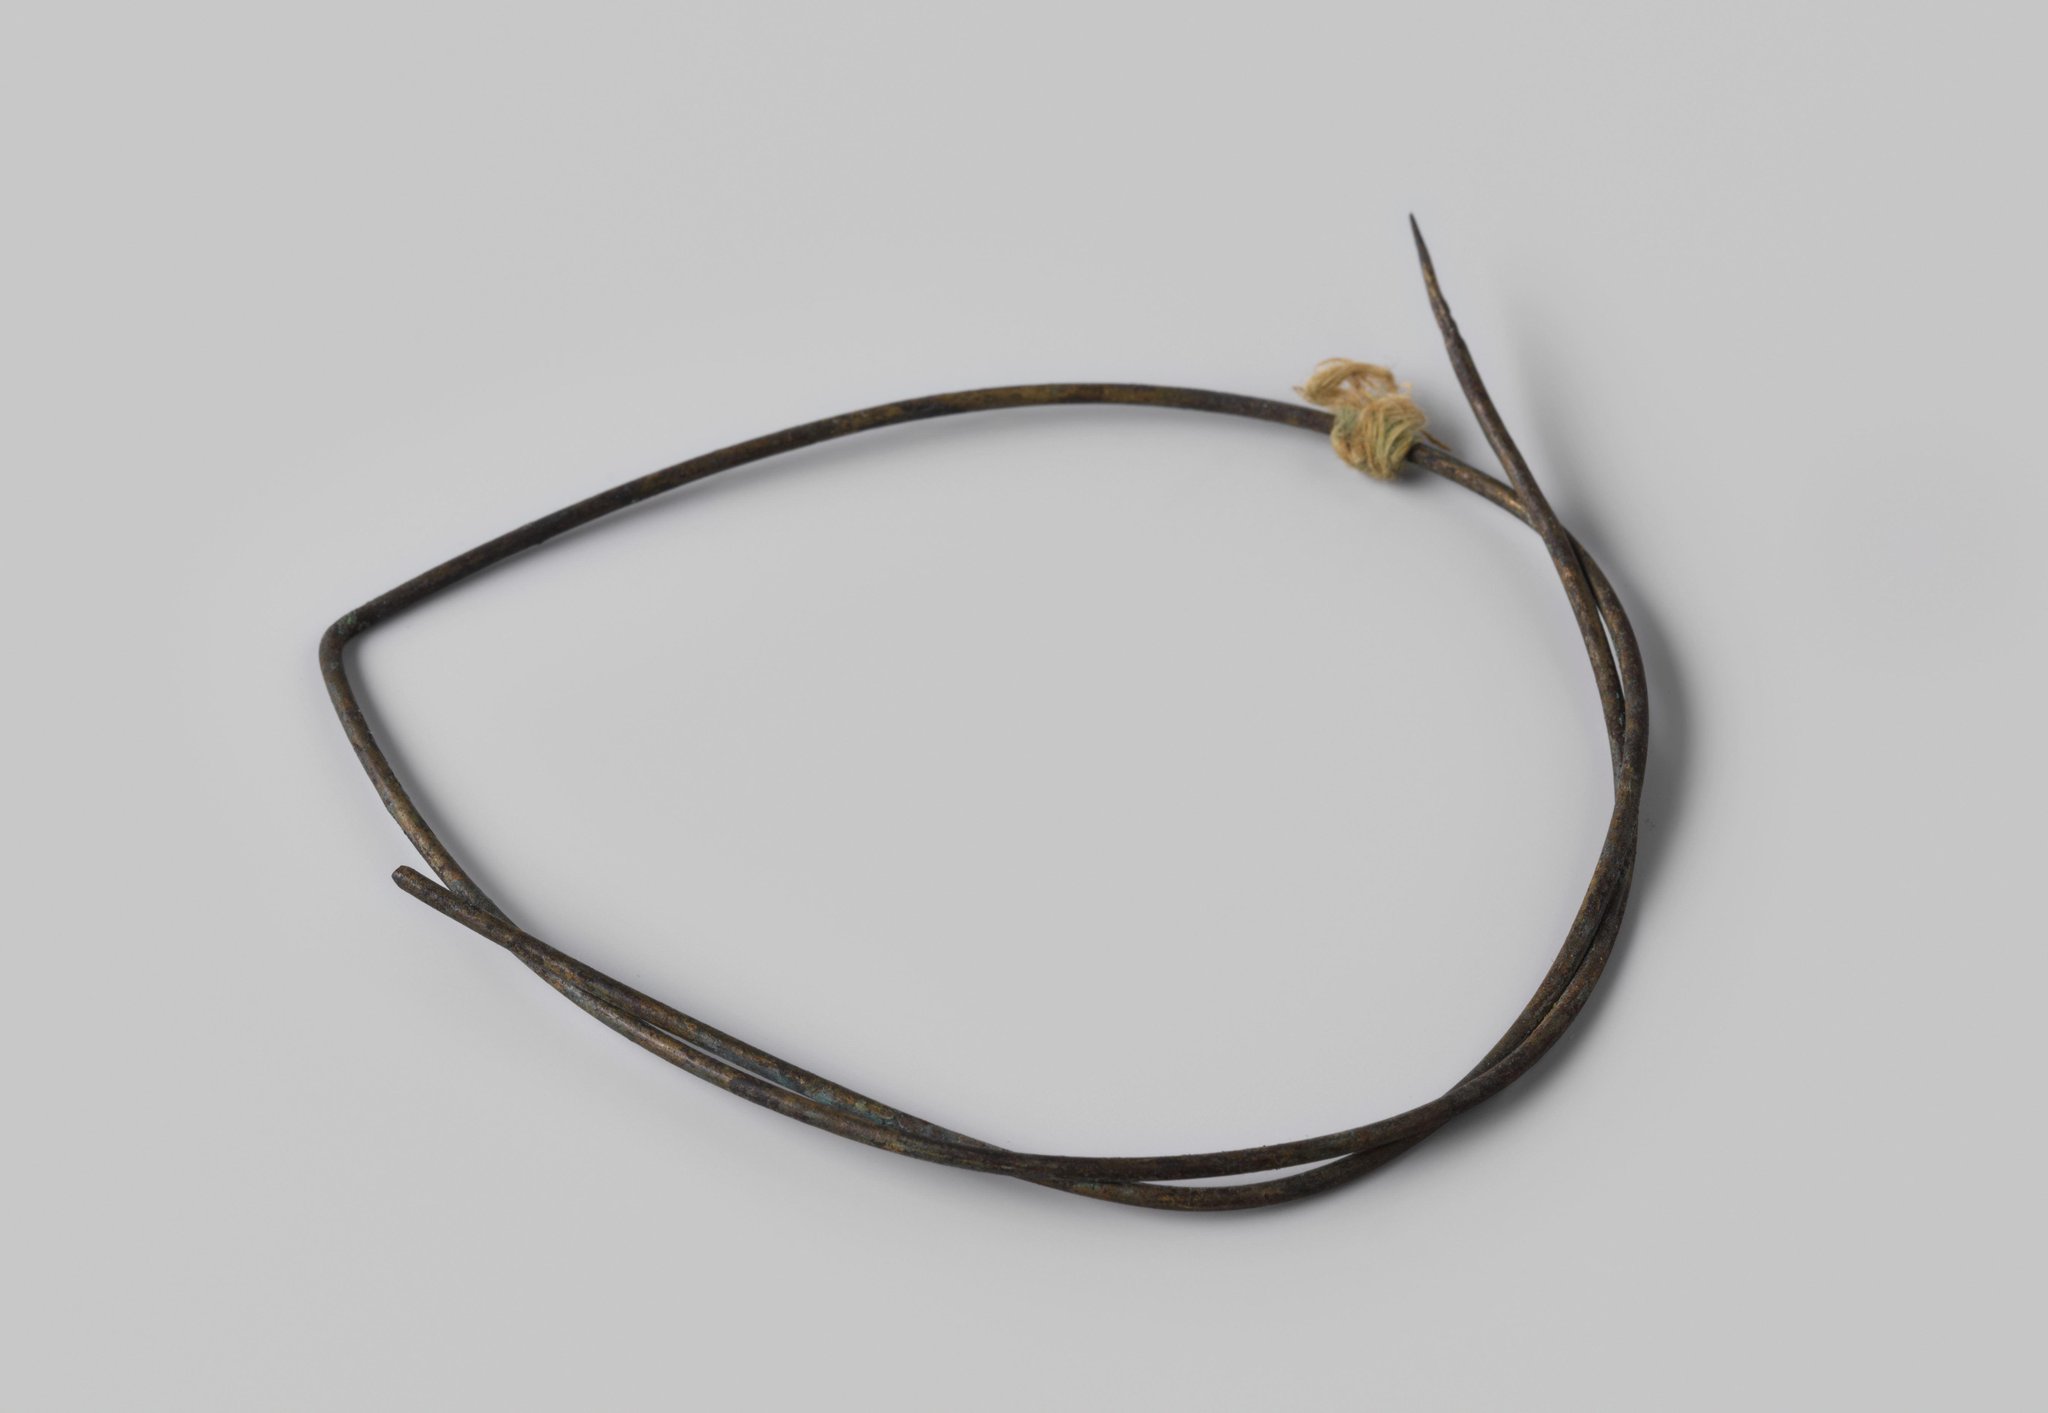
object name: wire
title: Opgerolde koperdraad uit het wrak van de Oost-Indiëvaarder Hollandia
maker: Anonymous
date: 1700-1743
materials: copper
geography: netherlands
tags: verenigde oostindische compagnie, hollandia (schip), annet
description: Varied parts or fragments, wire; circularly looped, circular in section, one end pointed, with fragm of cloth.